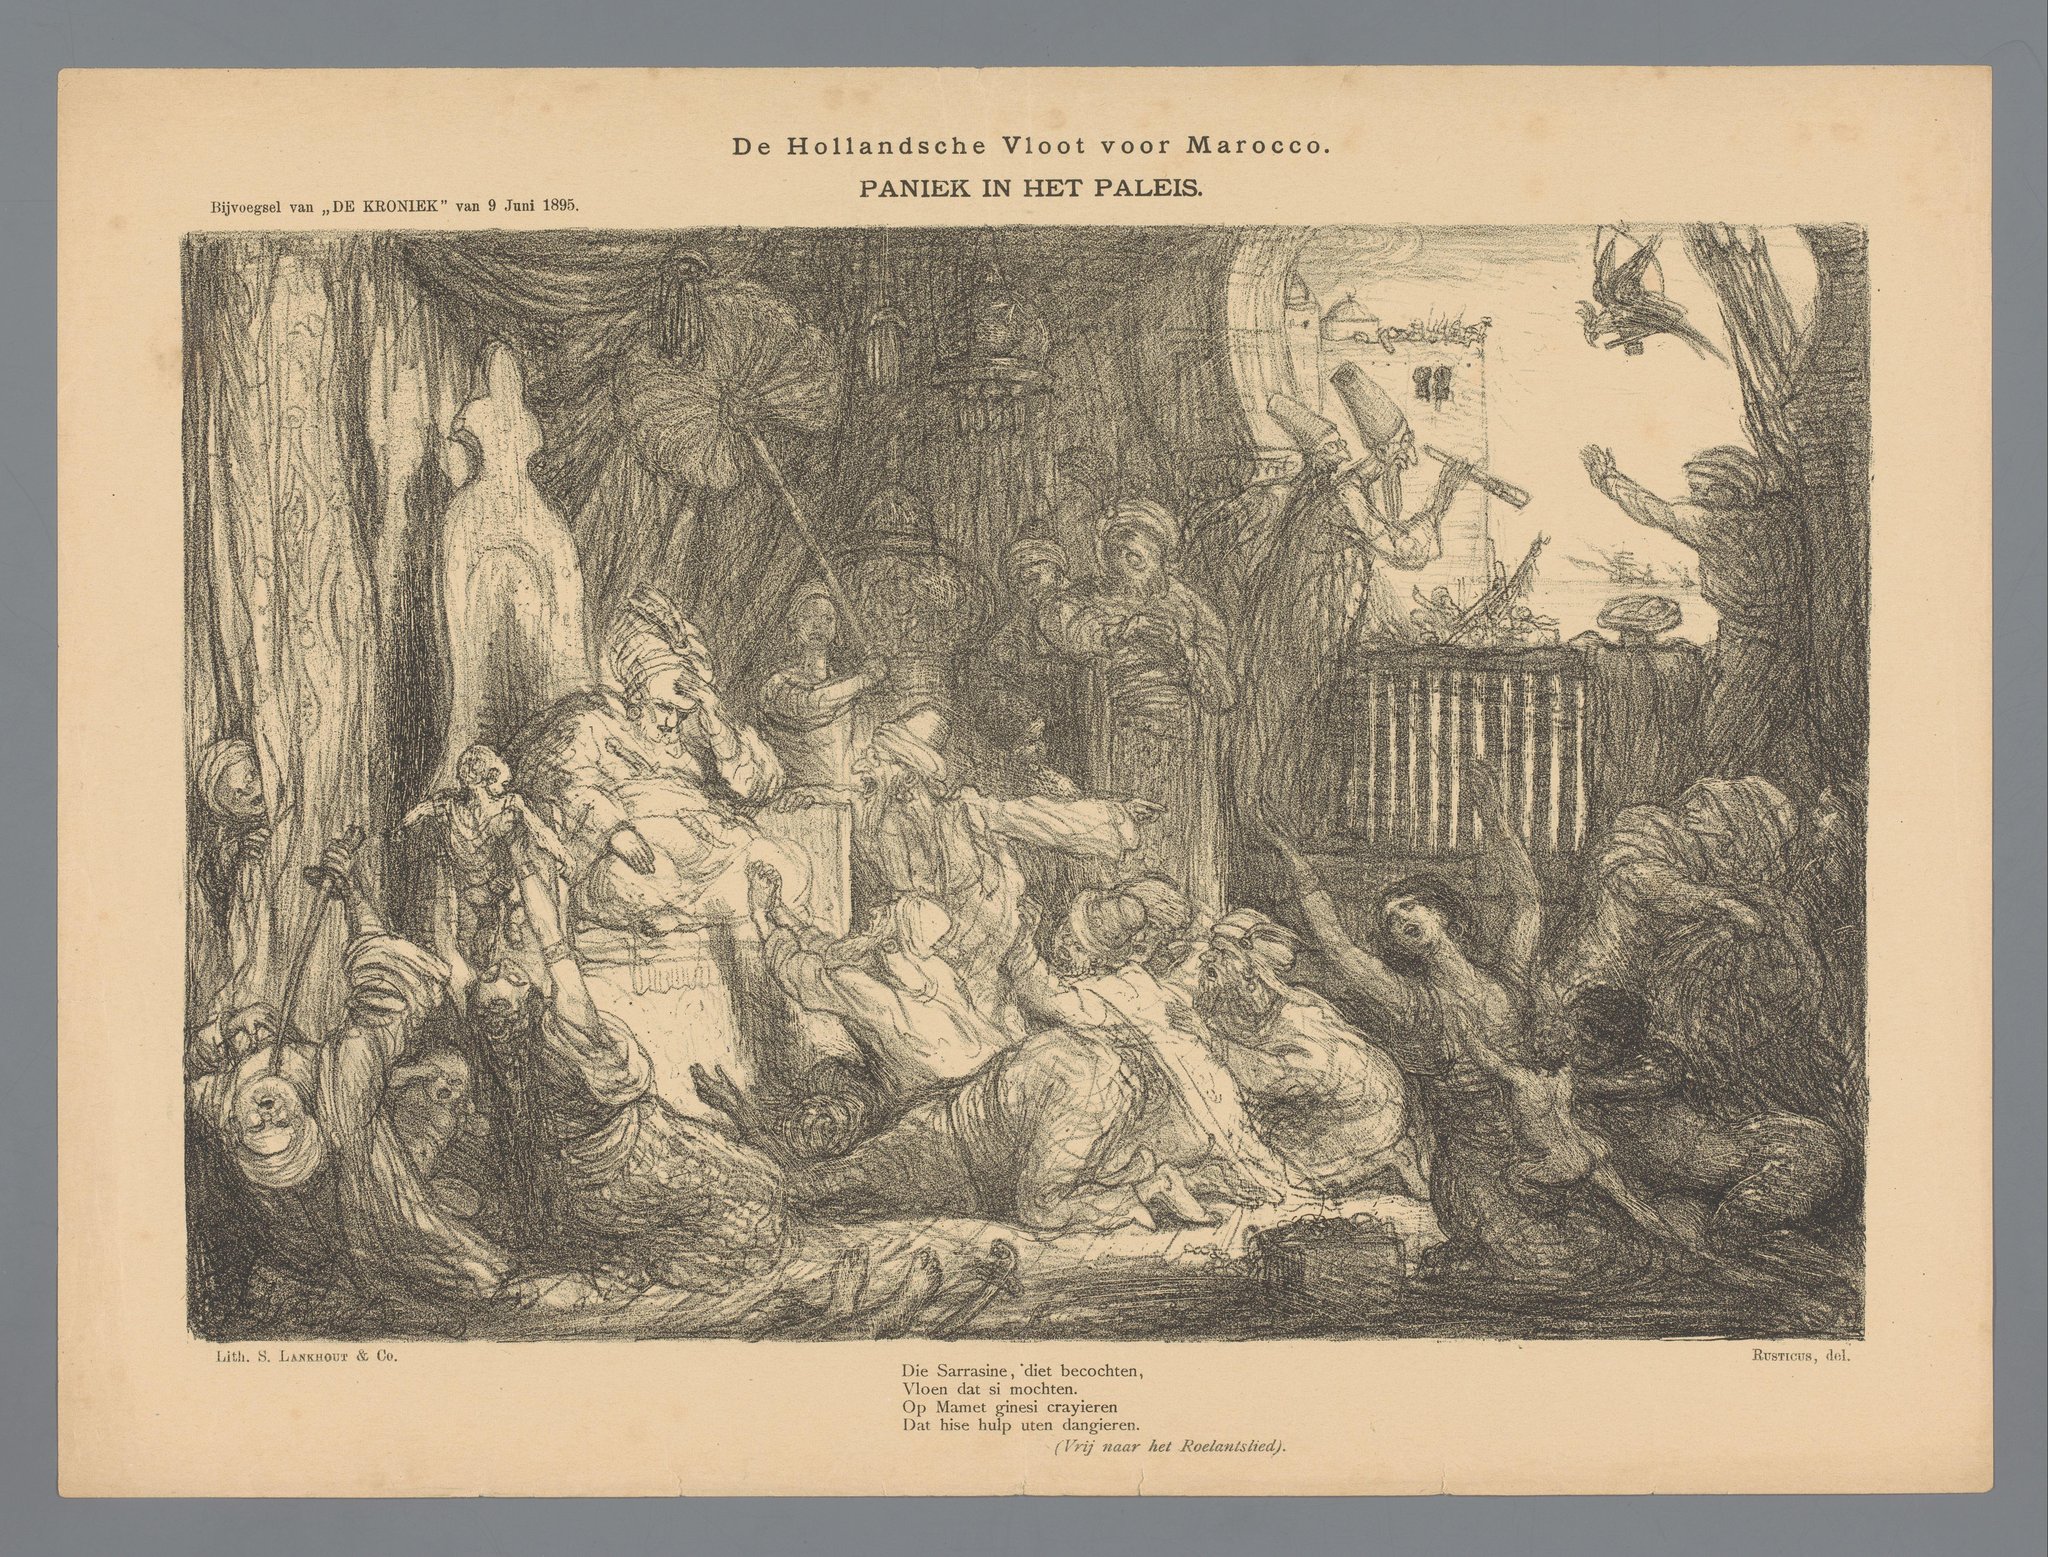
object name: cartoon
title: De Hollandsche Vloot voor Marocco. Paniek in het paleis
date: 1895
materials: paper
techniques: lithograph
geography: amsterdam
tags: political caricatures and satires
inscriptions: date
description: Spotprent op het sturen van de Nederlandse vloot naar Marokko in 1895. Als represaille op het overvallen door Marokkaanse piraten van het Nederlandse schip Anna in april 1895 stuurde de regering een eskader oorlogsschepen dat bij Tanger voor de kust bleef liggen. In het paleis van de sultan heerst paniek en wanhoop. Onderaan een vierregelig versje. Verschenen in de bijvoegsel van 'De Kroniek' van 9 juni 1895.